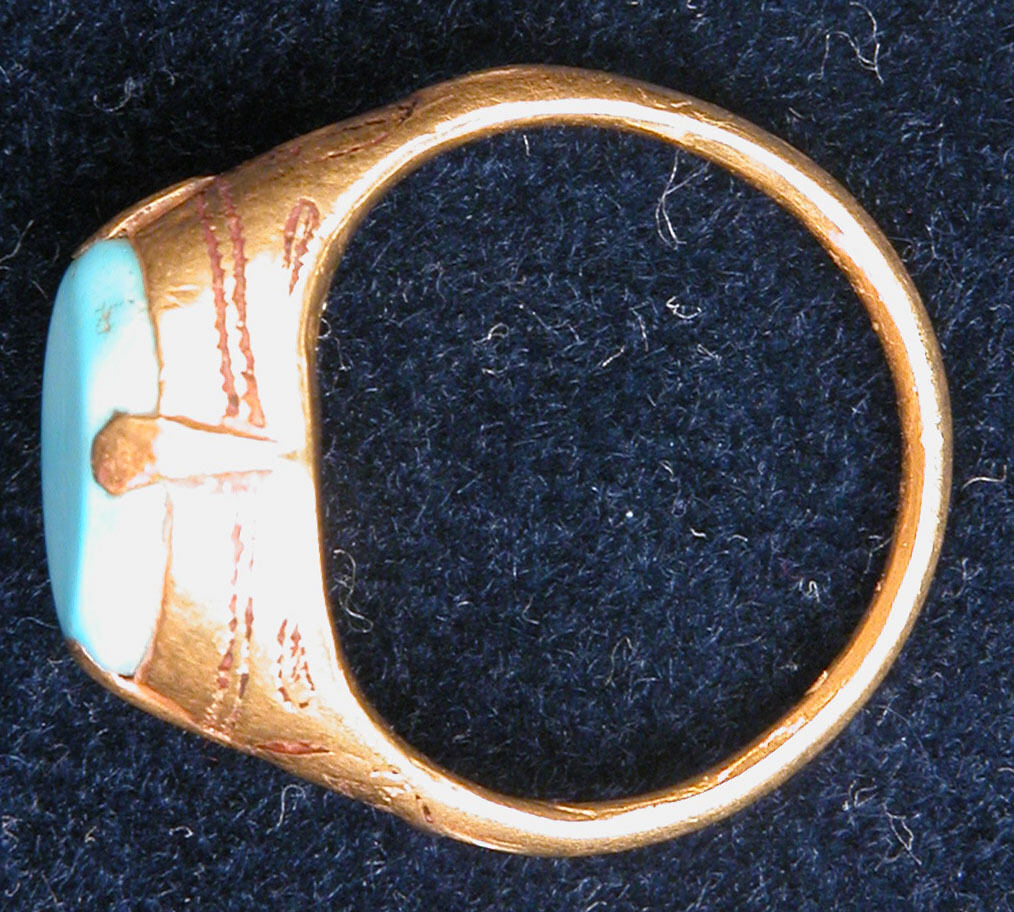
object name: ring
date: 1101-1300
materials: gold, stone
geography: iran